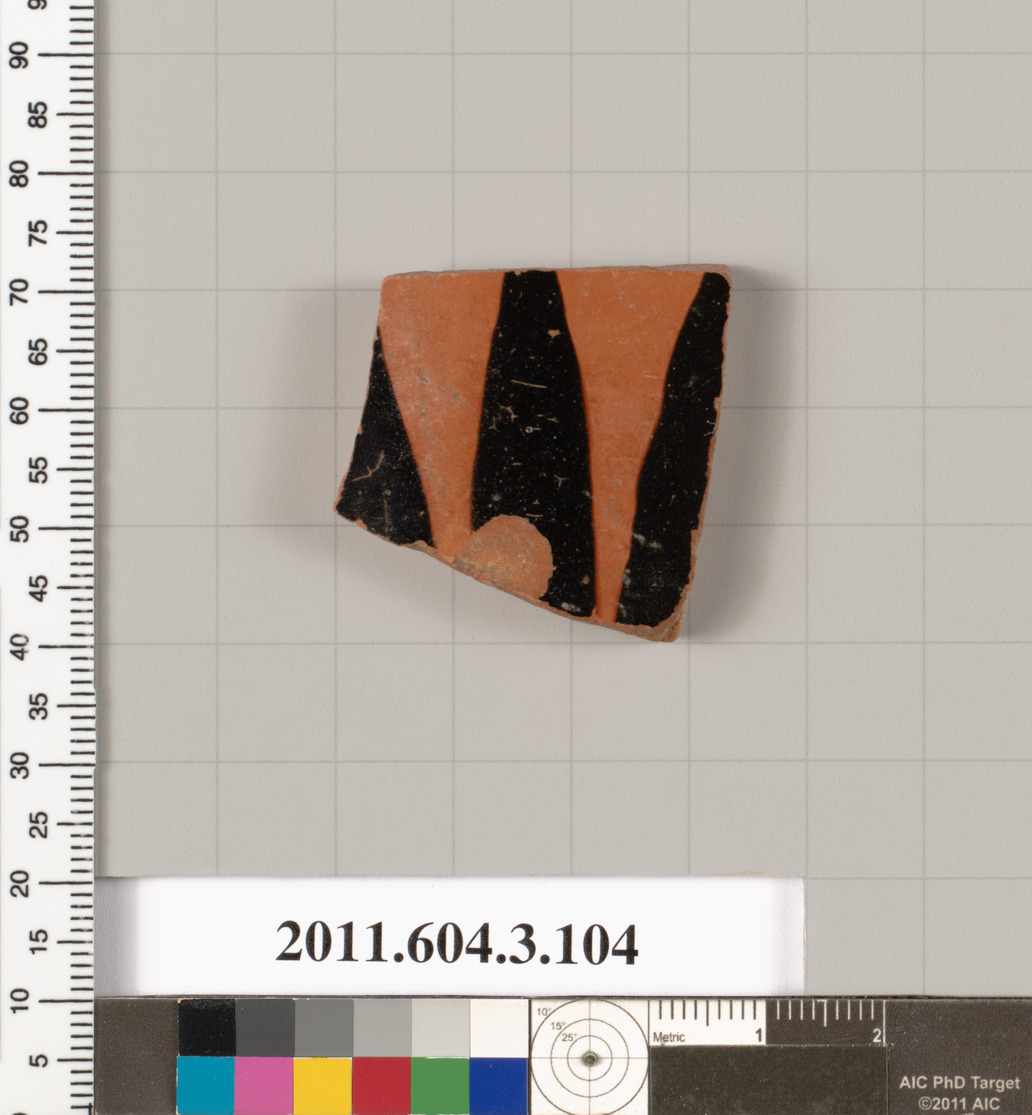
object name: amphora fragment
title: Terracotta fragment of an amphora (jar)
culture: greek, attic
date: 600-468 BCE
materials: terracotta